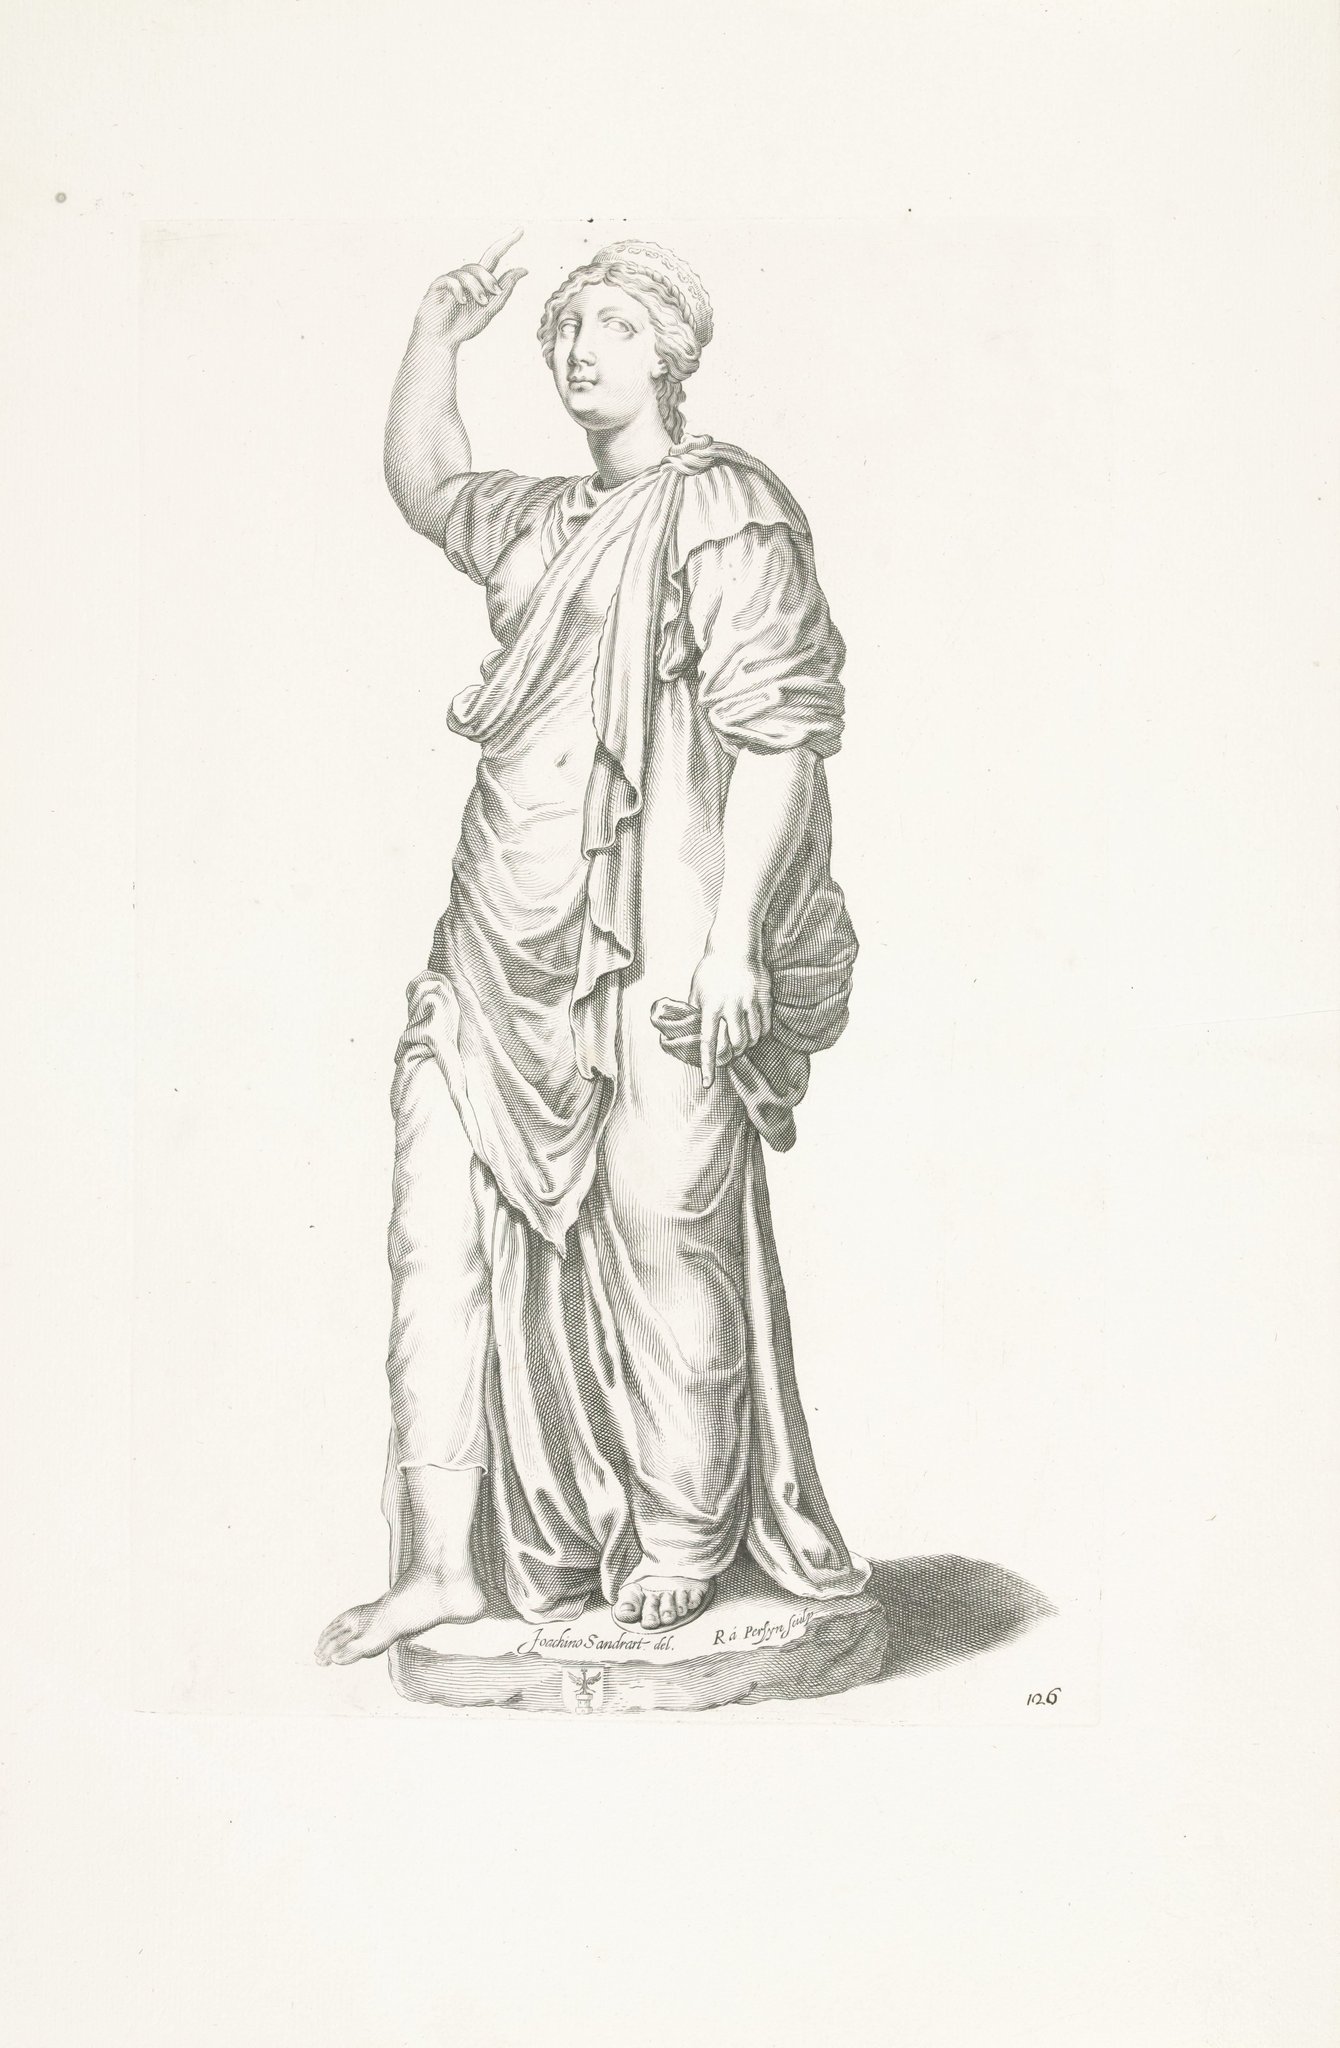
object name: print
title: Galleria Giustiniana del Marchese Vincenzo Giustiniani I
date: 1640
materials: paper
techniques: engraving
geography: rome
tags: vincenzo giustiniani (1564-1637), adult woman, piece of sculpture, reproduction of a piece of sculpture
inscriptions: collector's mark: Lugt 2228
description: Standbeeld van een vrouw, in klassiek gewaad, met opgeheven arm. Midden onder op de basis het wapenschild van Vincenzo Giustiniani. Prent uit een publicatie met reproductieprenten naar de sculpturen in de verzameling in de Galleria Giustiniani te Rome.